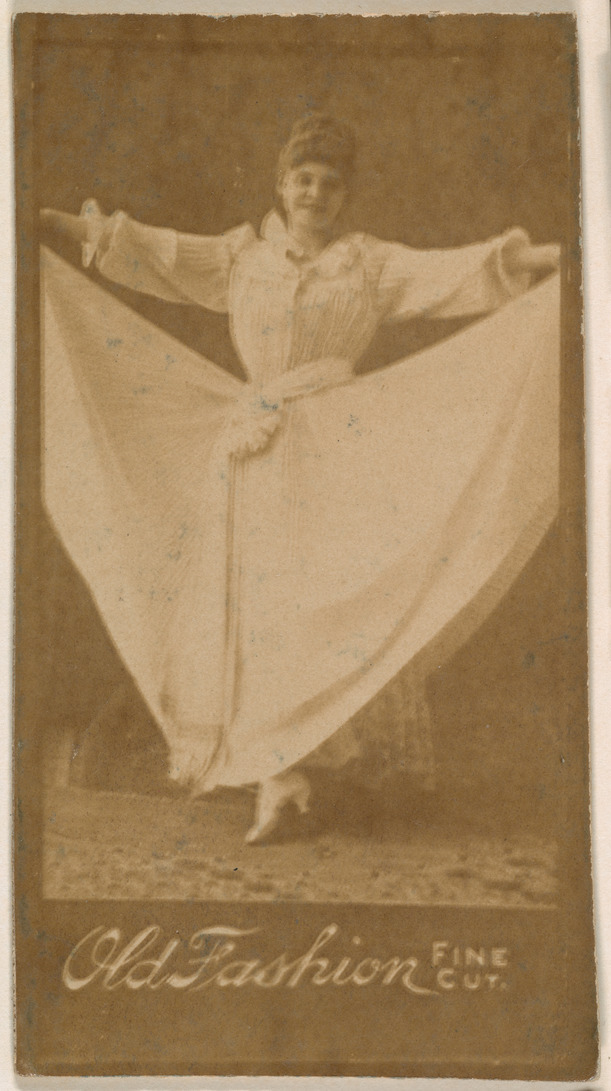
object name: photograph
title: Dancer, from the Actresses series (N664) promoting Old Fashion Fine Cut Tobacco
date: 1888-1890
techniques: albumen silver print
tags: portraits,women,dancers